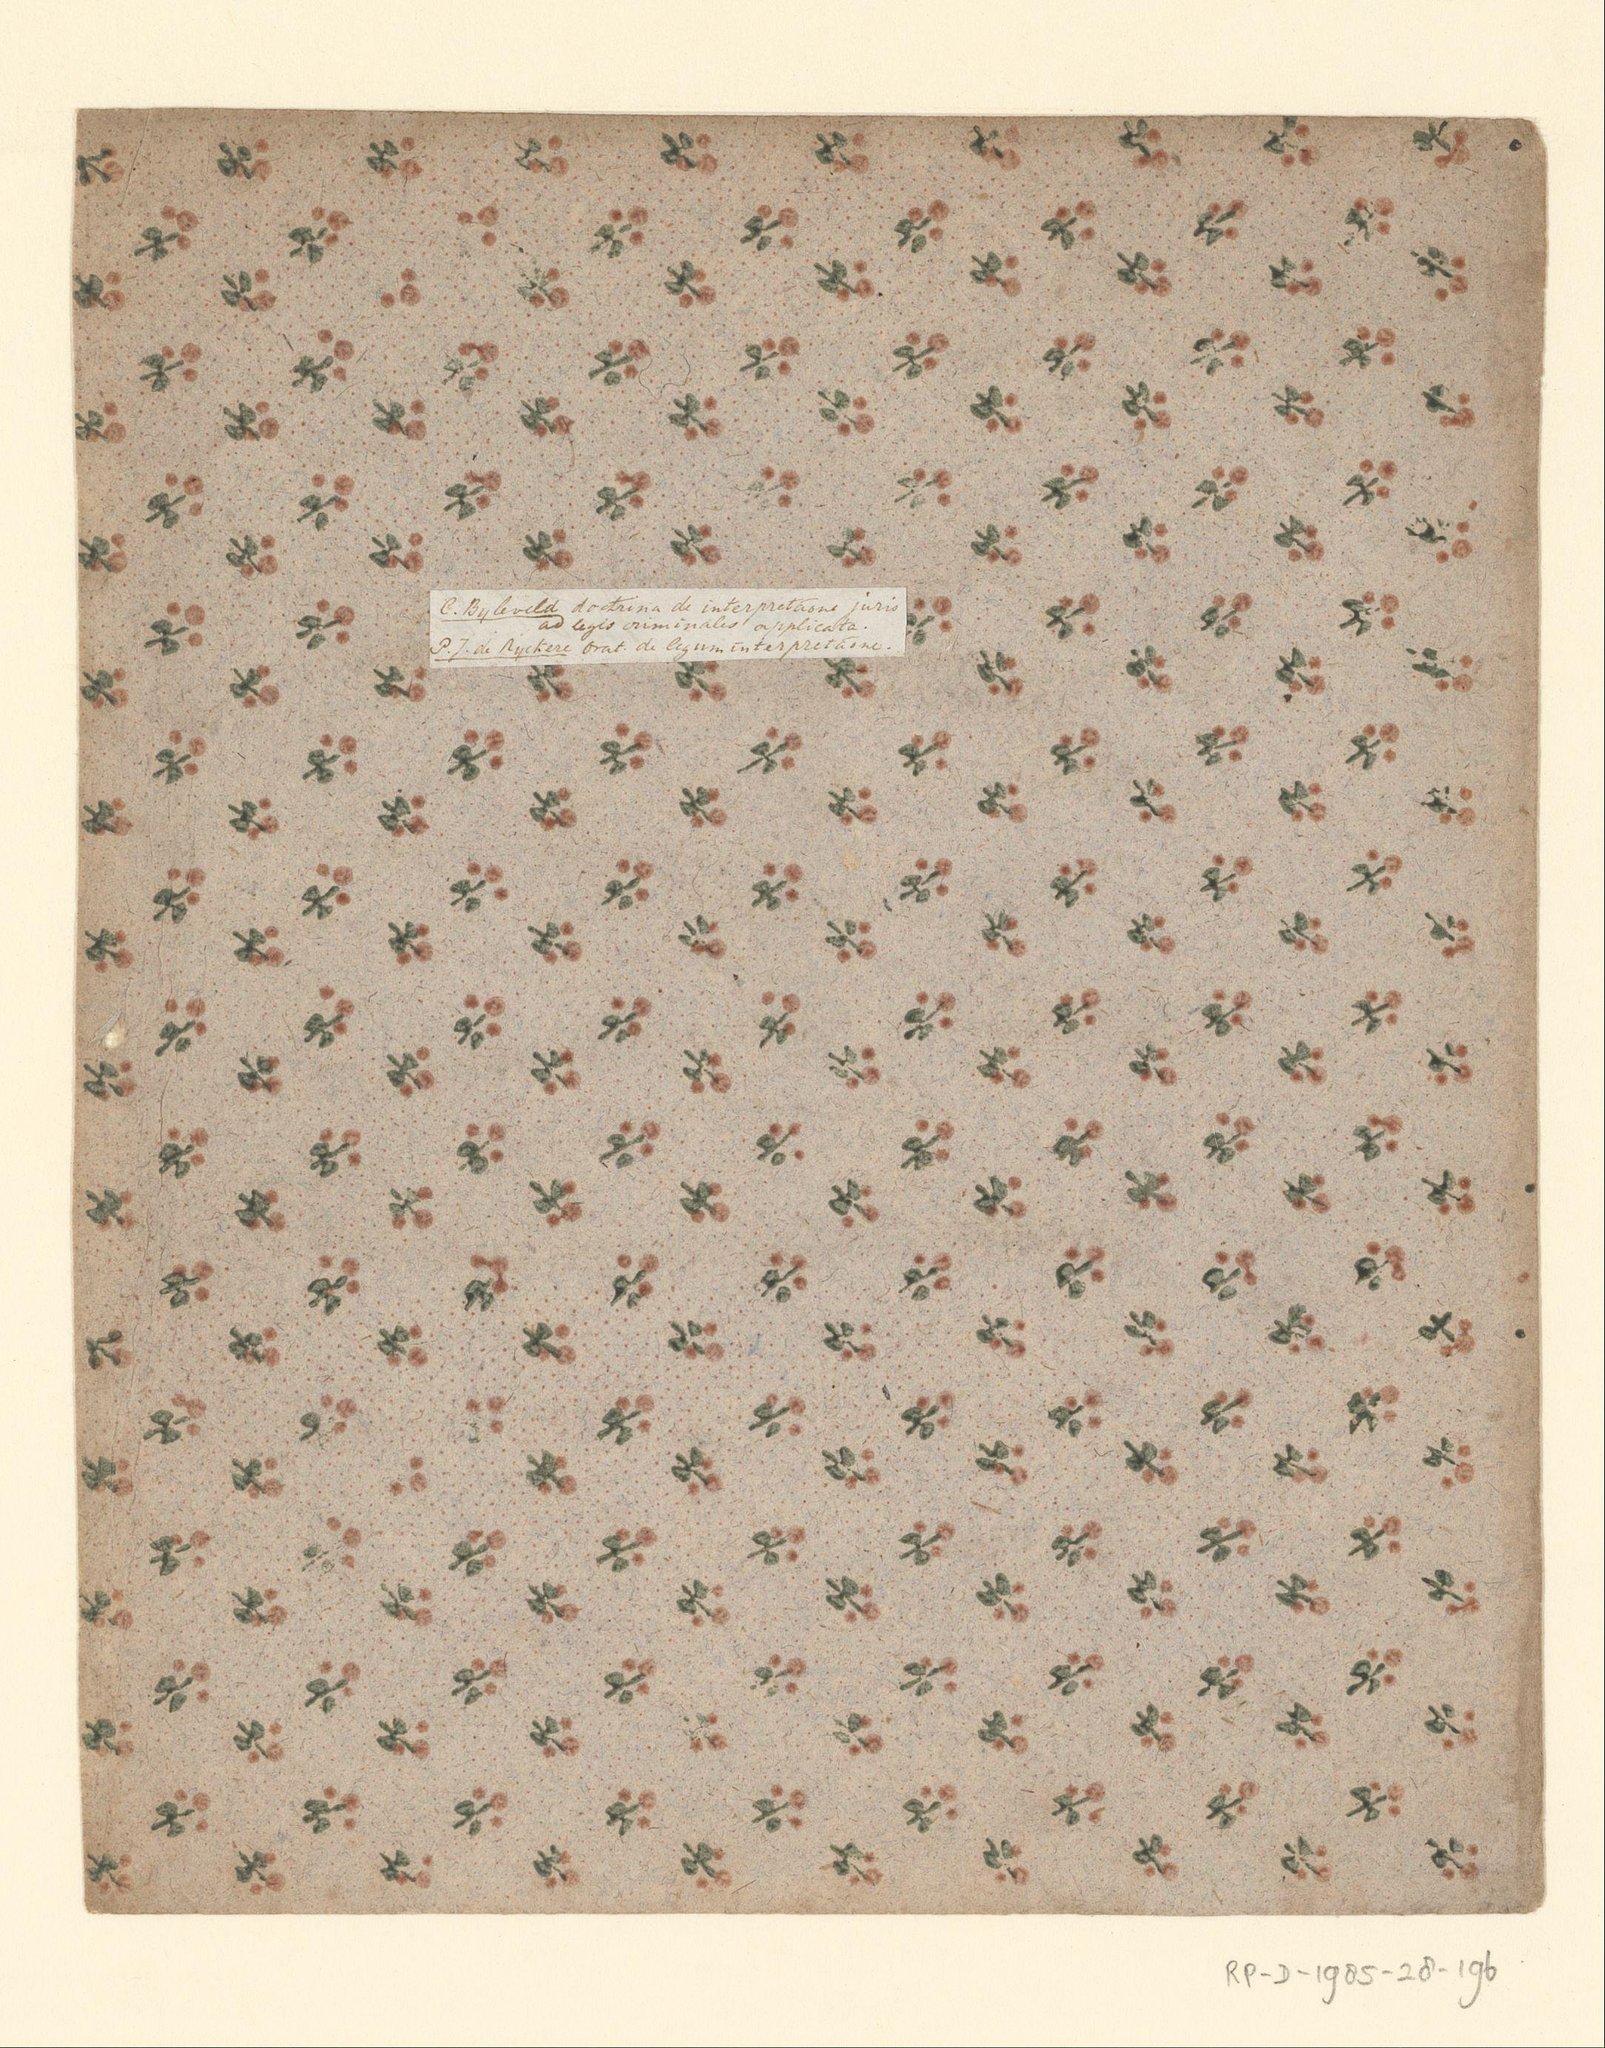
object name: printed paper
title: Blad met strooipatroon van bloemtakje op puntenfond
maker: Anonymous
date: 1750-1900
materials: paper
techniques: printing block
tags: ornament derived from plant forms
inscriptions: collector's mark: Lugt 2760, collector's mark: Lugt 2228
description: Blad met strooipatroon van bloemtakje op puntenfond. Met etiket met opschrift: 'C. Bijleveld ... interpretaone'. Helft van een omslag.